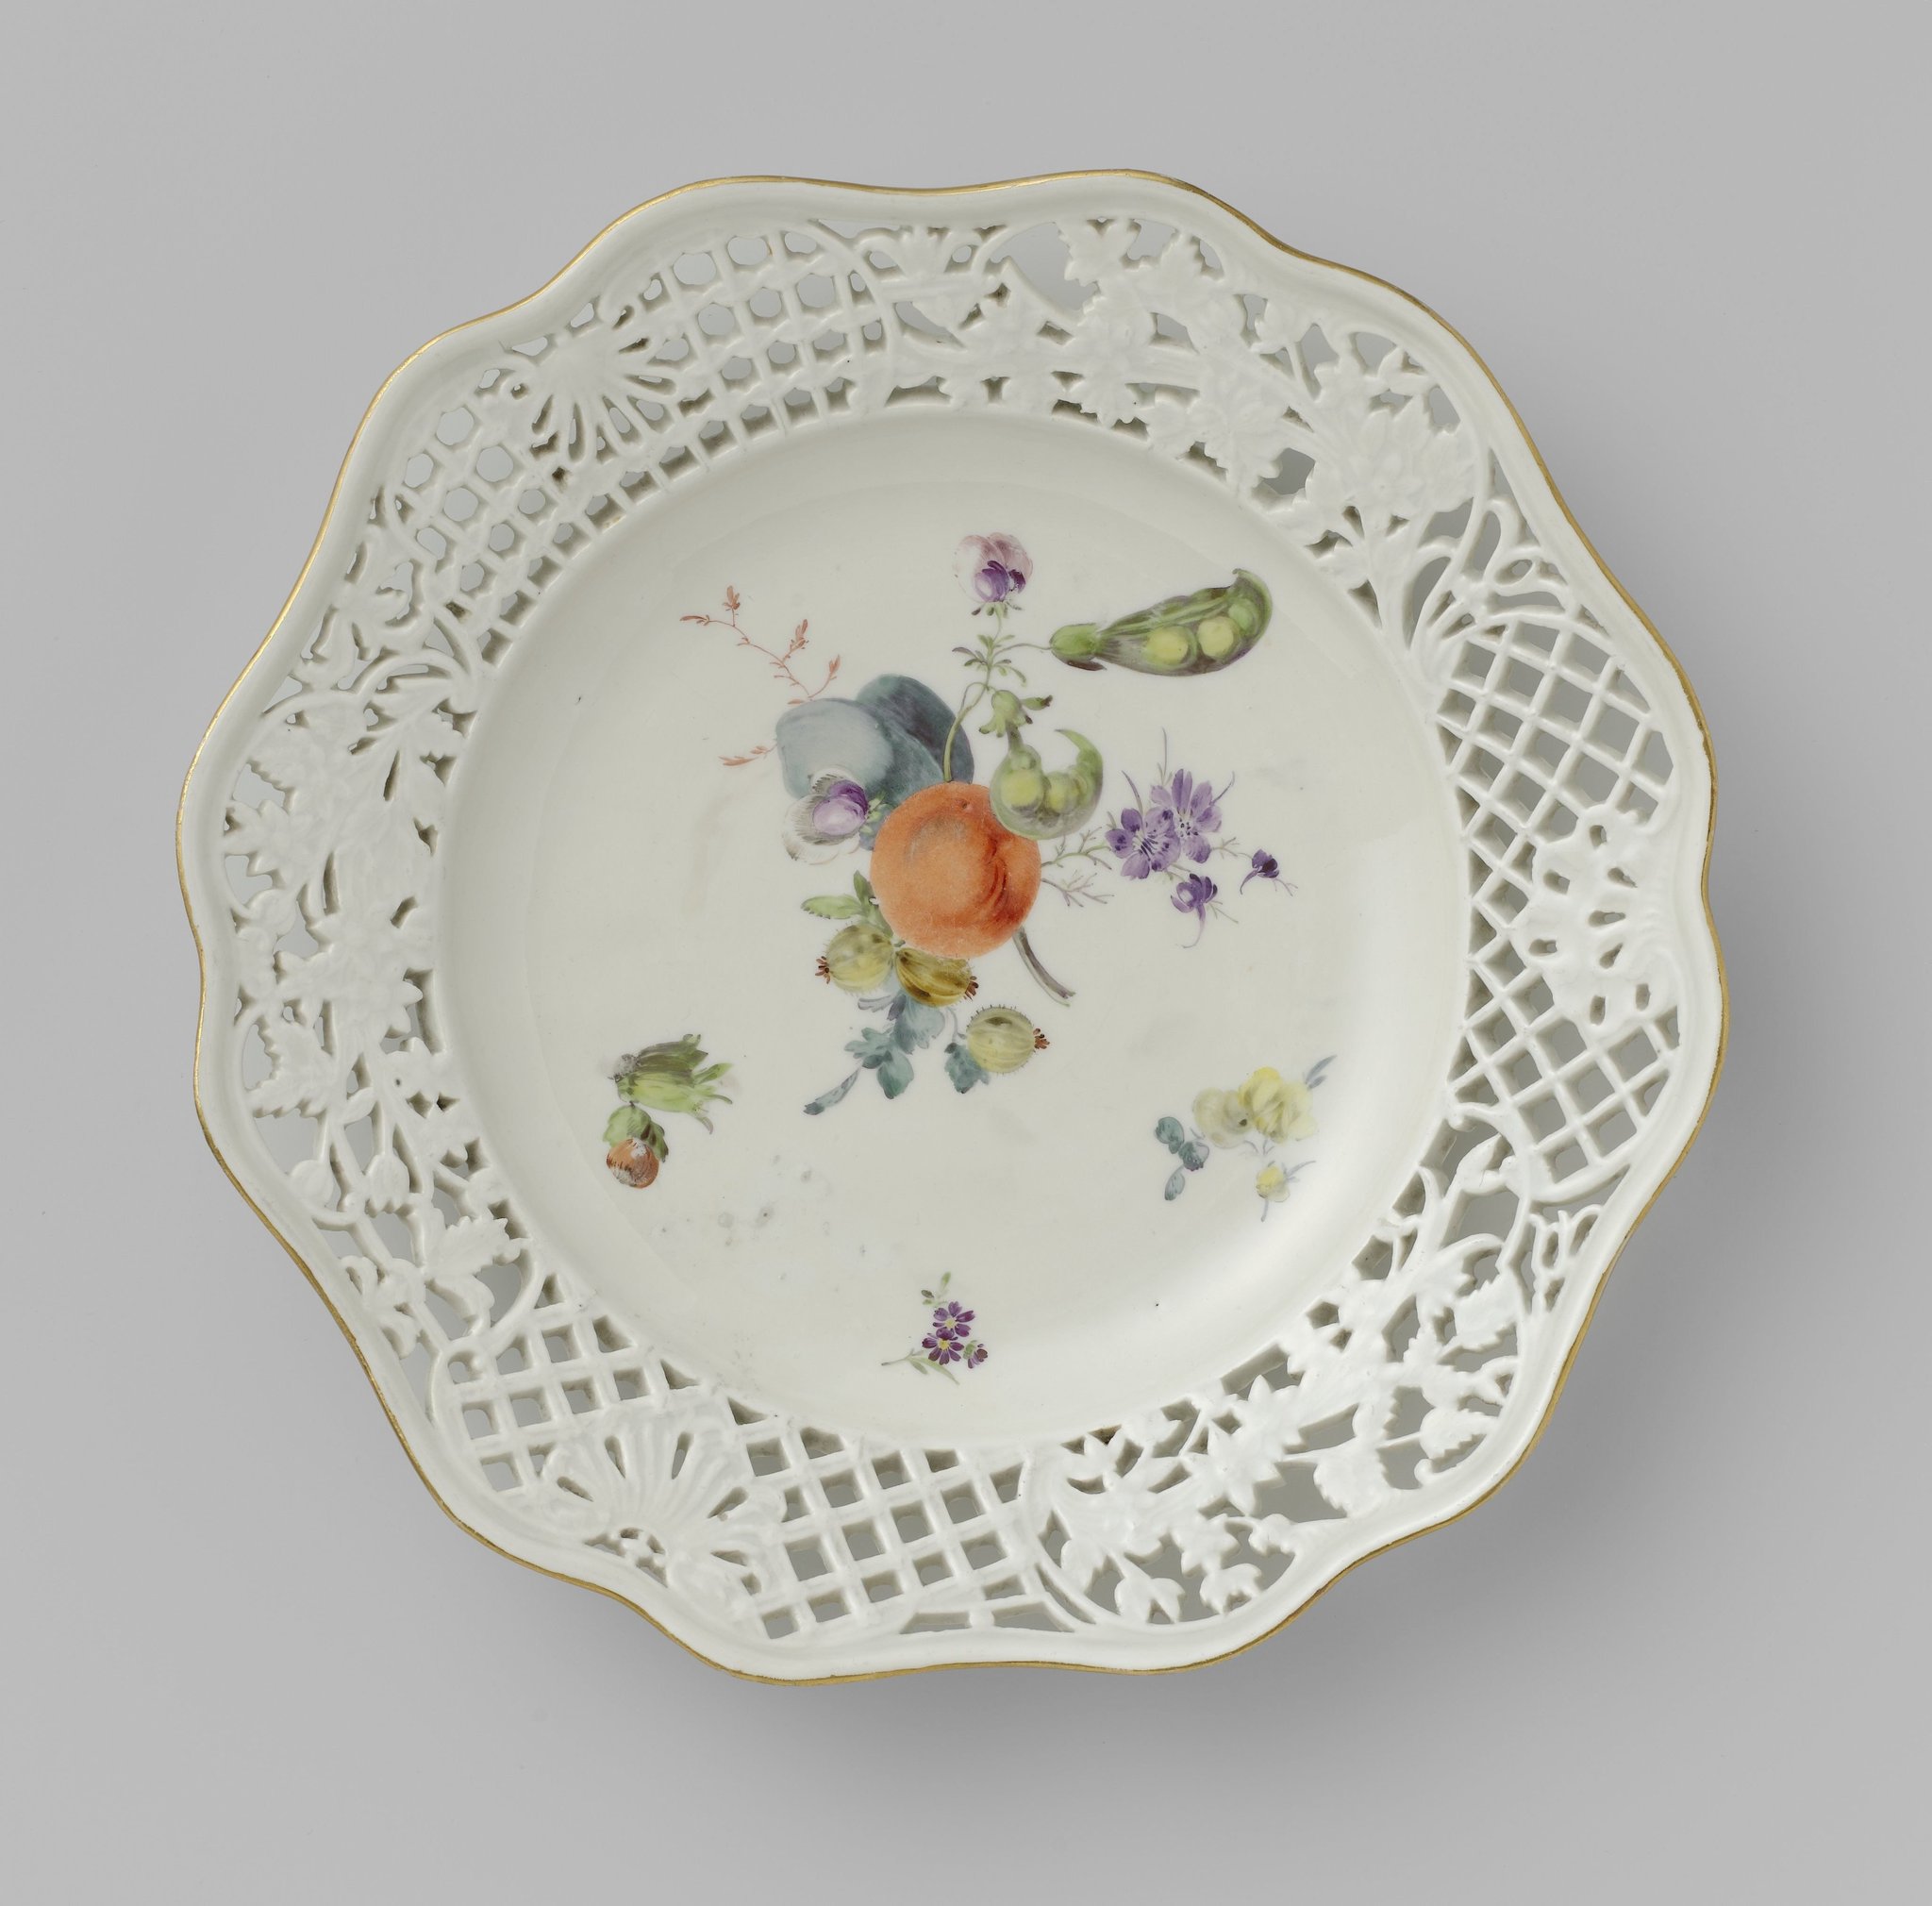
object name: dessert plate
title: Dessertbord, veelkleurig beschilderd met bloemen en vruchten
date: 1750-1760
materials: porcelain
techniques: painted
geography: meissen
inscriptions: mold mark, factory mark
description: Rond dessertbord van beschilderd porselein. De geschulpte rand is opengewerkt met afwisselend een netwerk met een palmet en takken met bladeren en bloemen. De spiegel is beschilderd met bloemen en vruchten. Het bord is gemerkt.